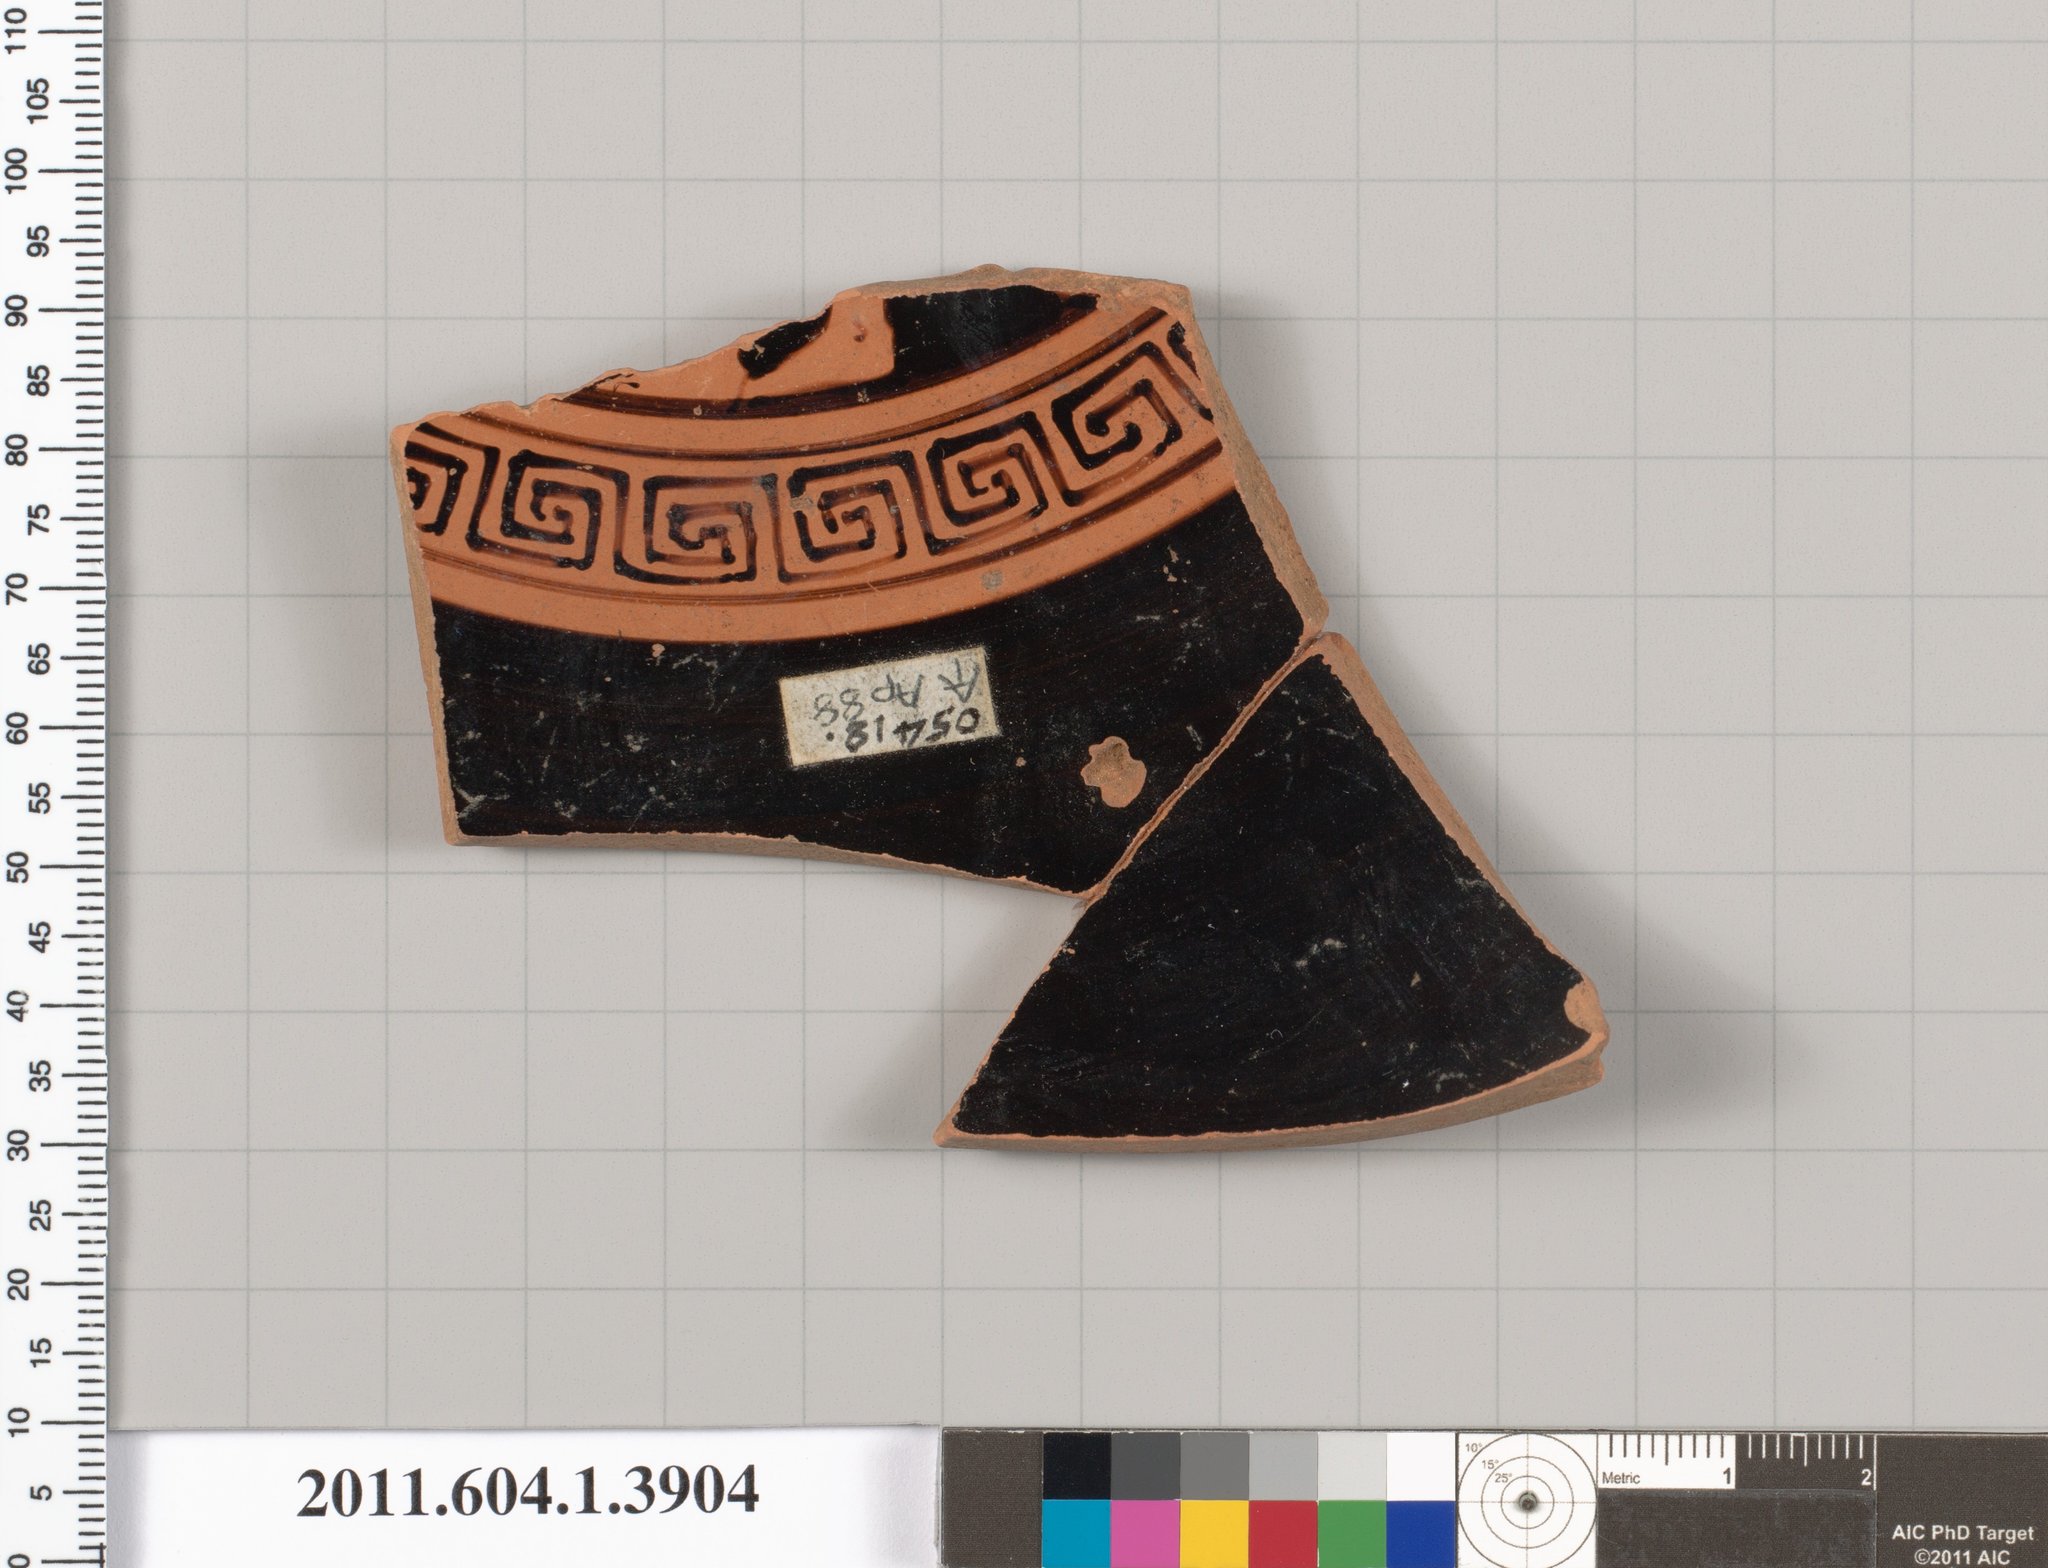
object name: kylix fragment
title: Terracotta fragment of a kylix (drinking cup)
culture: greek, attic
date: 475-451 BCE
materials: terracotta